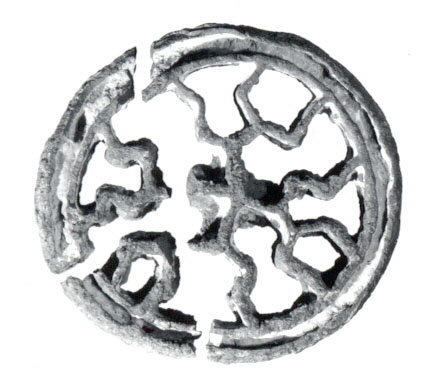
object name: stamp seal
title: Compartmented stamp seal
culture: bactria-margiana archaeological complex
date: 2333-1668 BCE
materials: copper alloy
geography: bactria-margiana